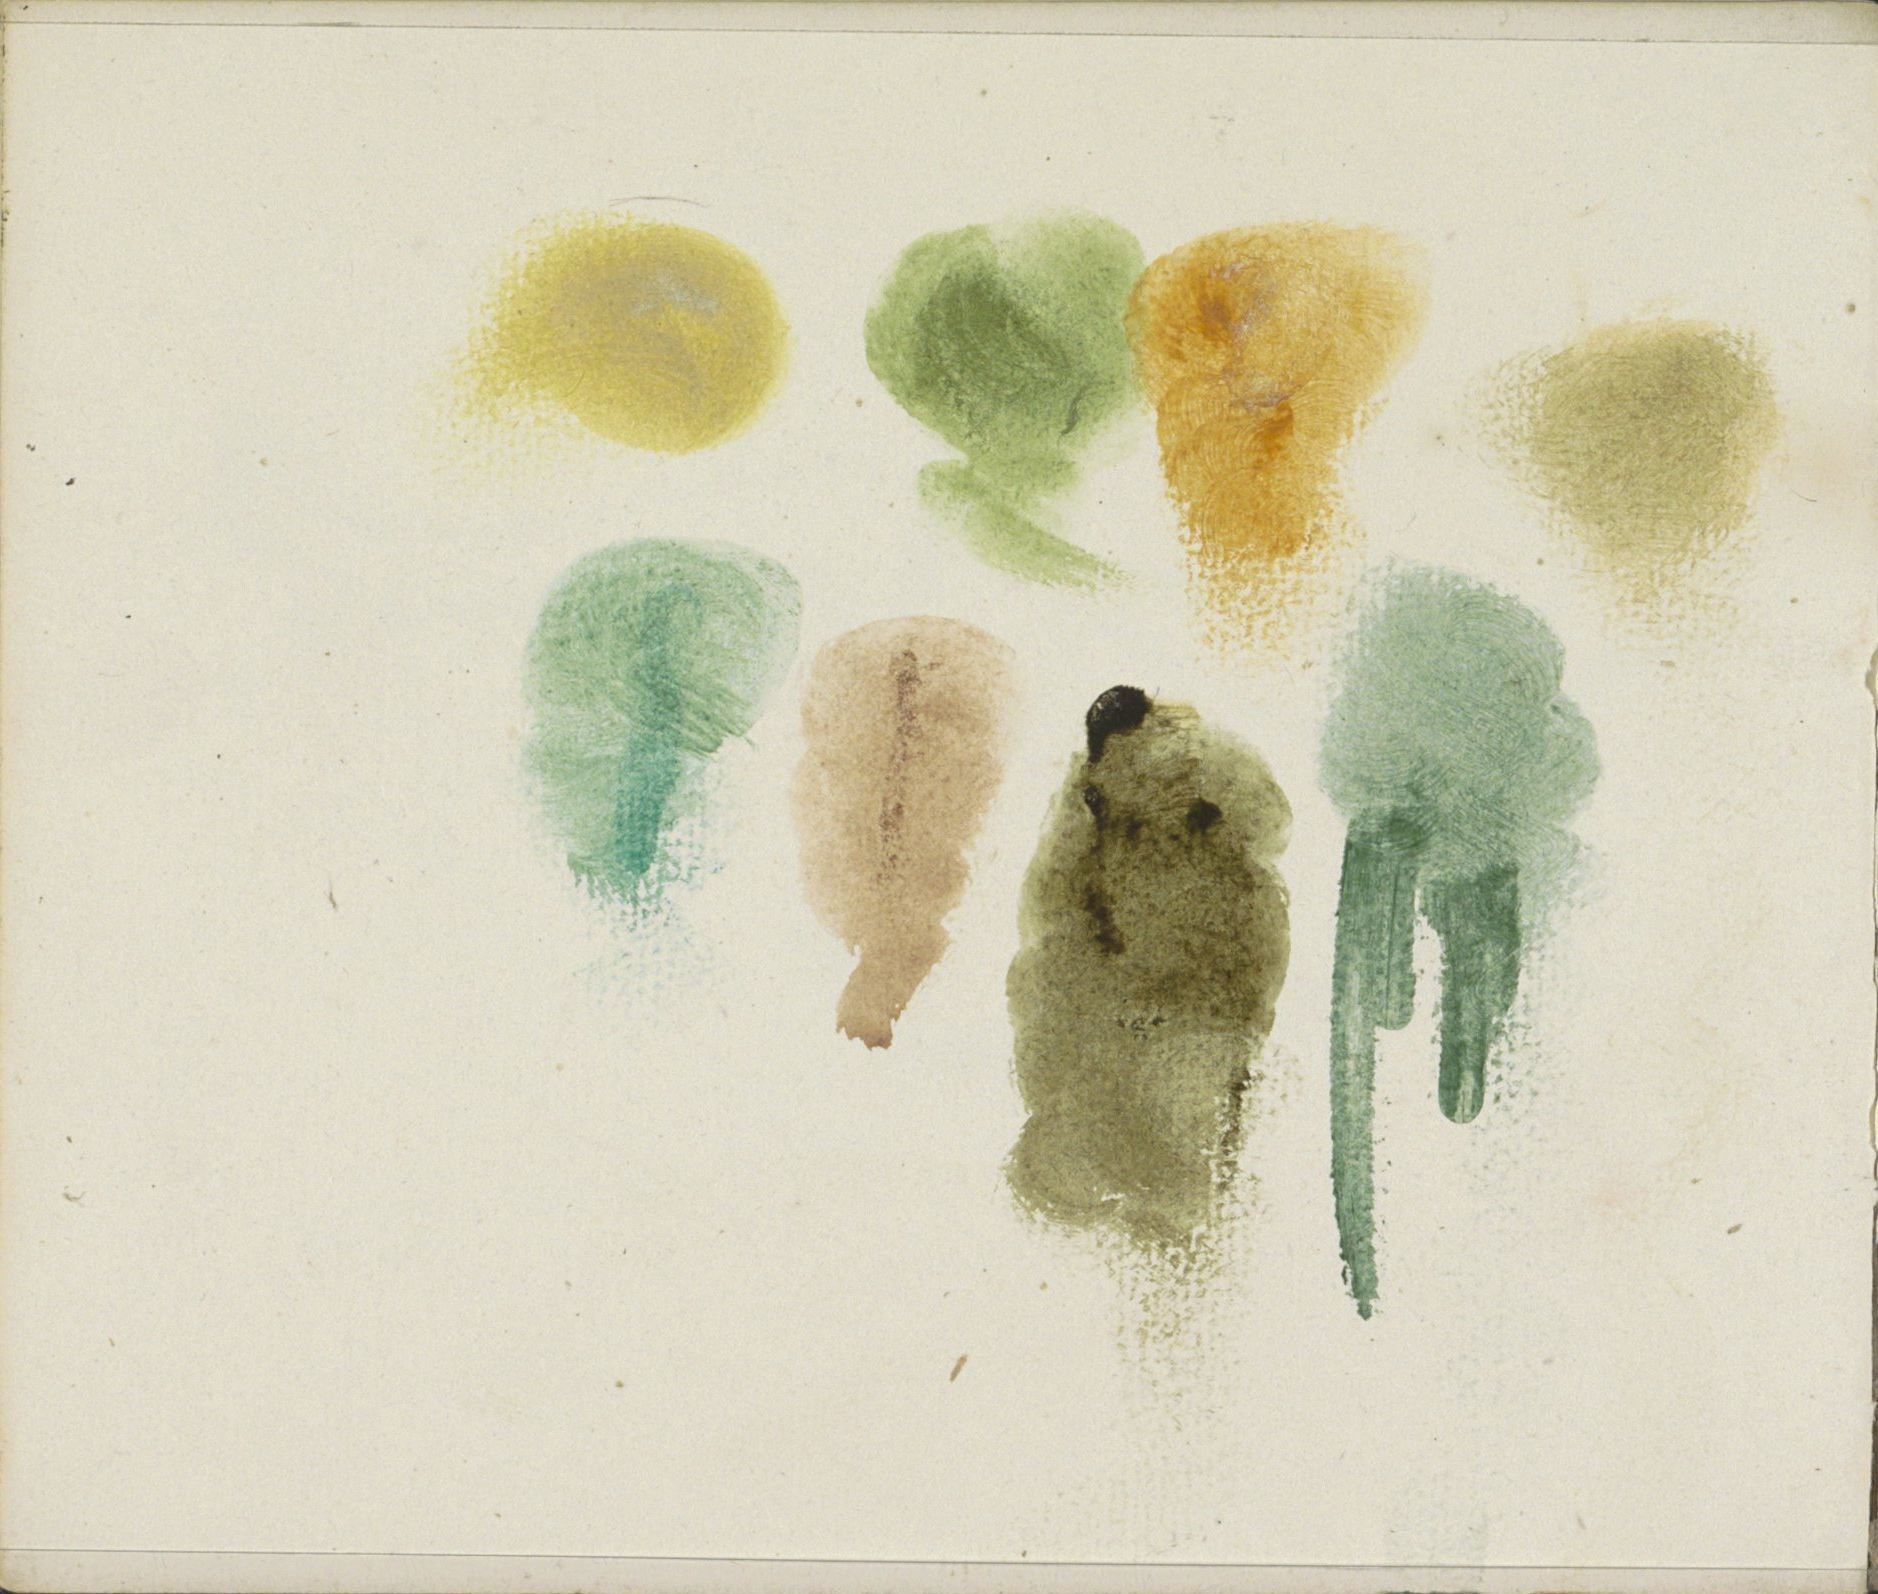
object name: sketchbook leaf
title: Studieblad met kleurproeven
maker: willem witsen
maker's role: draughtsman, painter, print maker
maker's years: 1860-1923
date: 1915-1920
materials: paper, watercolor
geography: amsterdam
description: Blad 9 verso uit een schetsboek met 12 bladen.